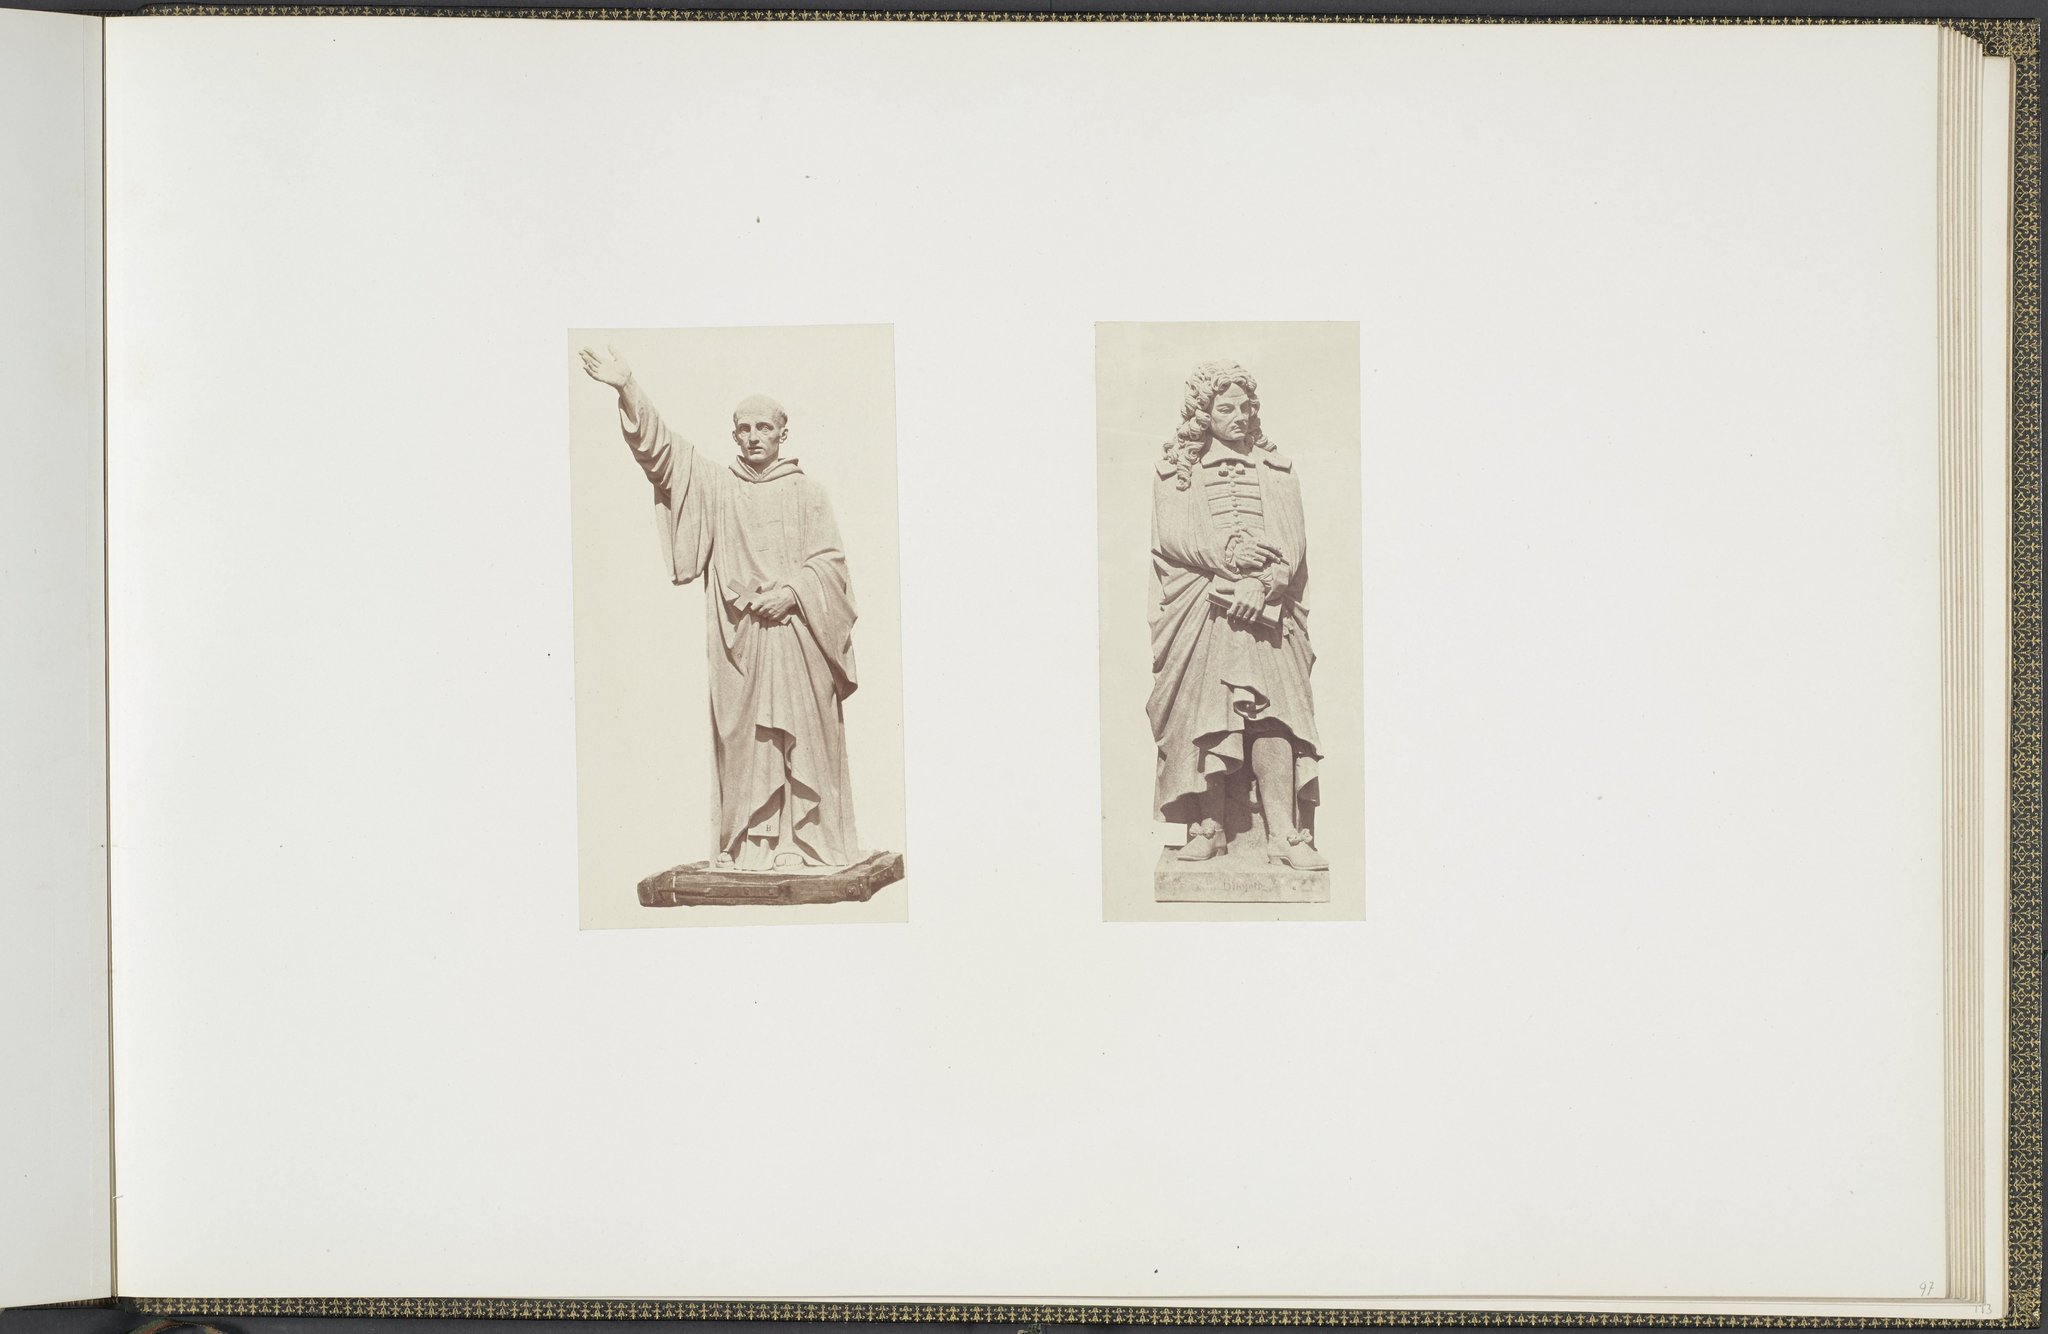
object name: photograph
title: Gipsmodellen voor beeldhouwwerken op het Palais du Louvre: links "Saint Bernard" door François Jouffroy en rechts "La Bruyère" door Joseph Stanislas Lescorné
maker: édouard denis baldus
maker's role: fotograaf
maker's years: 1813-1889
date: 1855-1857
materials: paper, photographic support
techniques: salted paper print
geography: paris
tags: piece of sculpture, reproduction of a piece of sculpture, permanent exhibition, museum, paris, tuileries palace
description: Onderdeel van Réunion des Tuileries au Louvre 1852-1857, album 1.